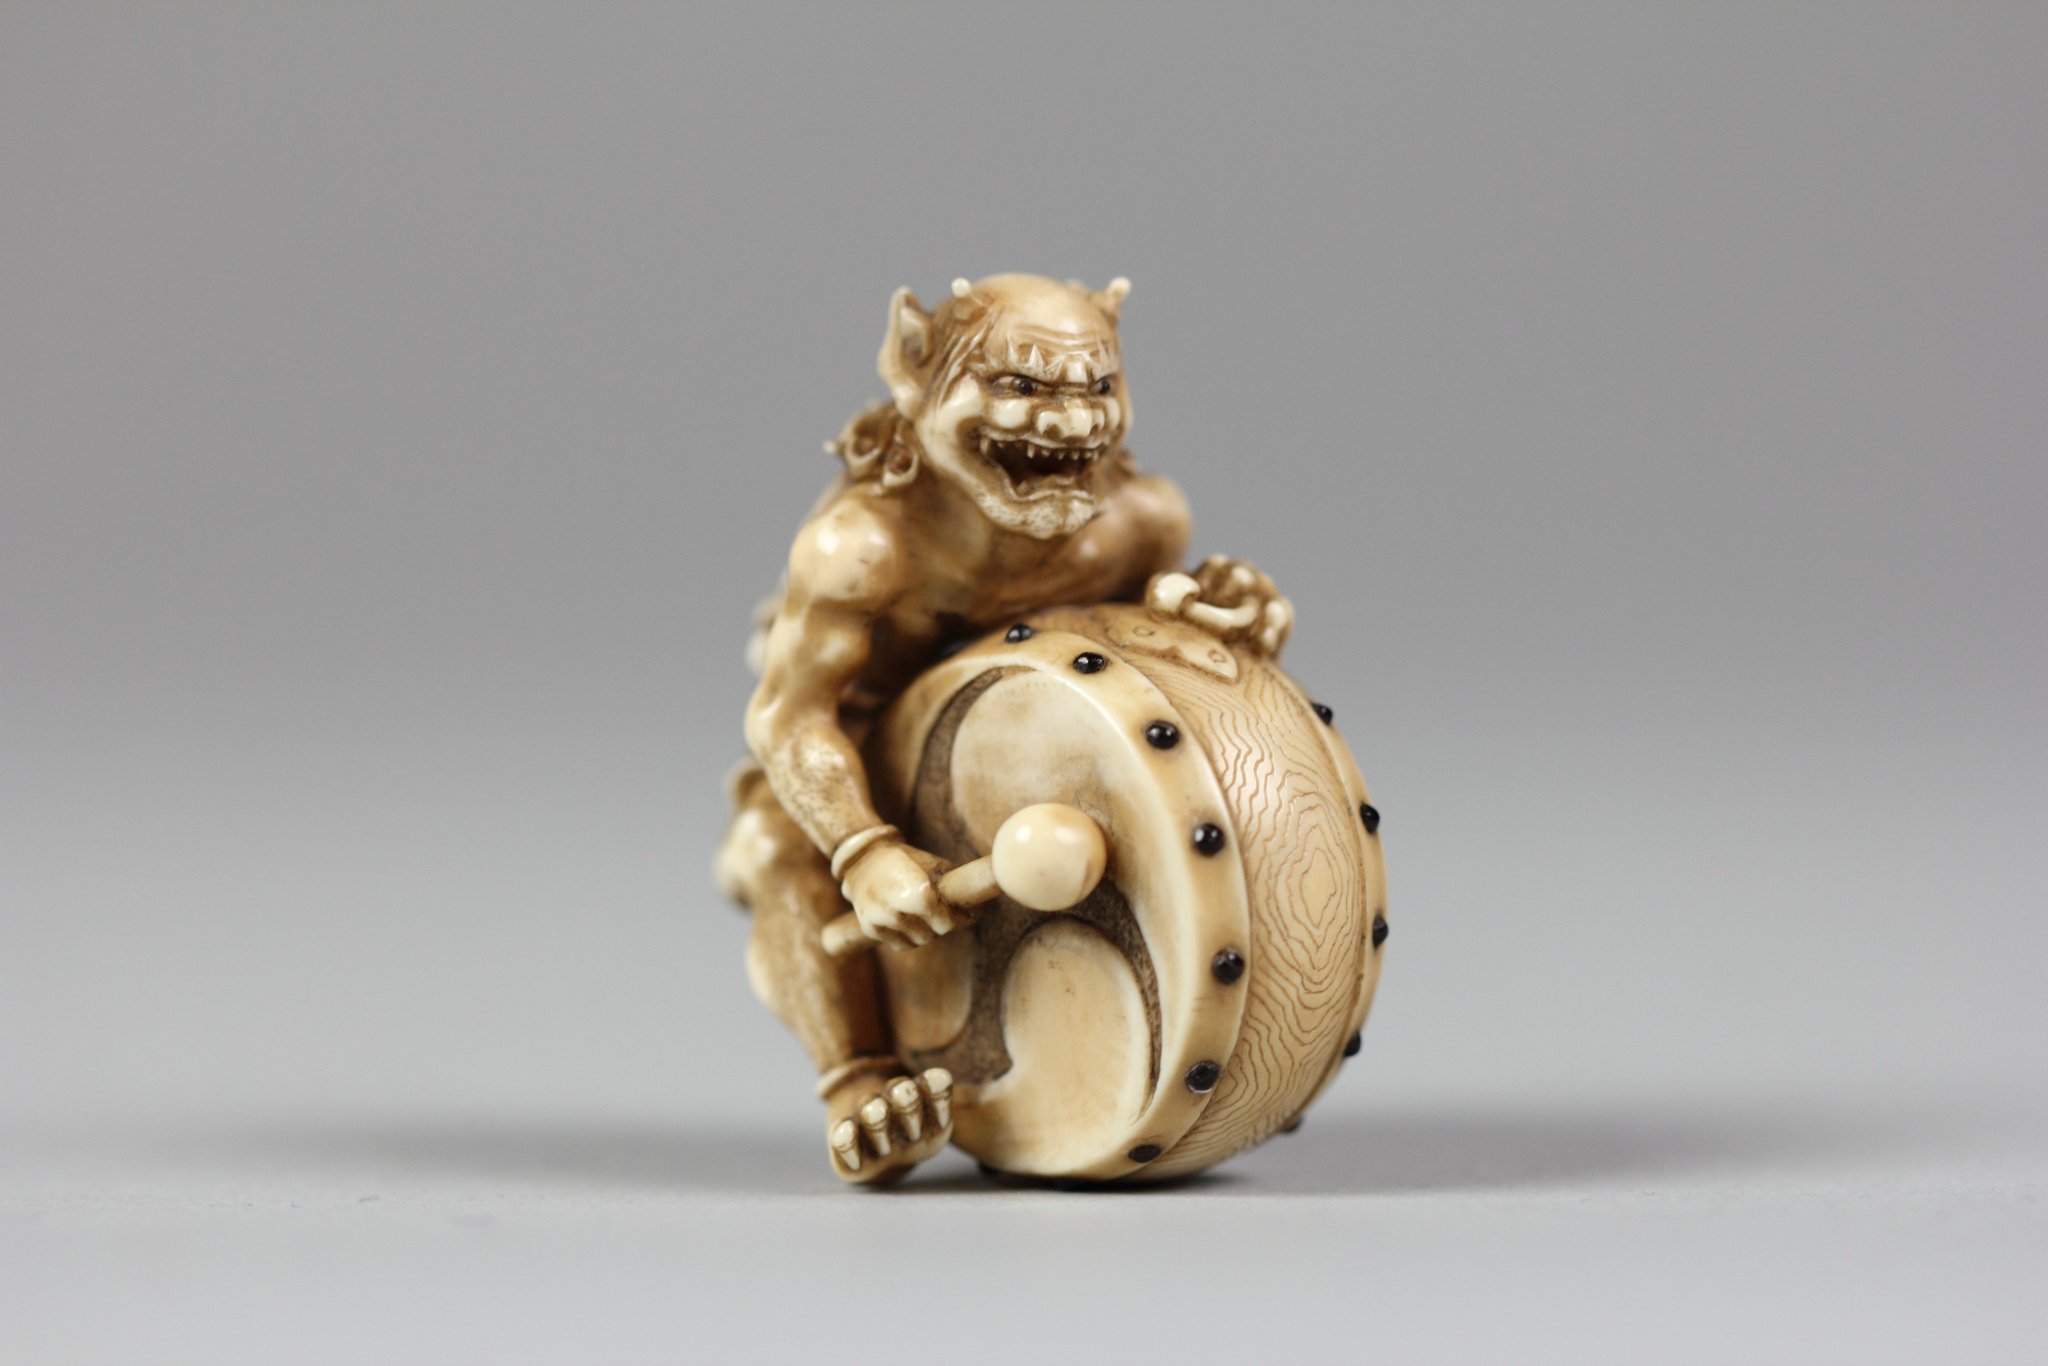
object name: netsuke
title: Netsuke of Demon with a Drum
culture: japanese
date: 1701-1900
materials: ivory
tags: drums